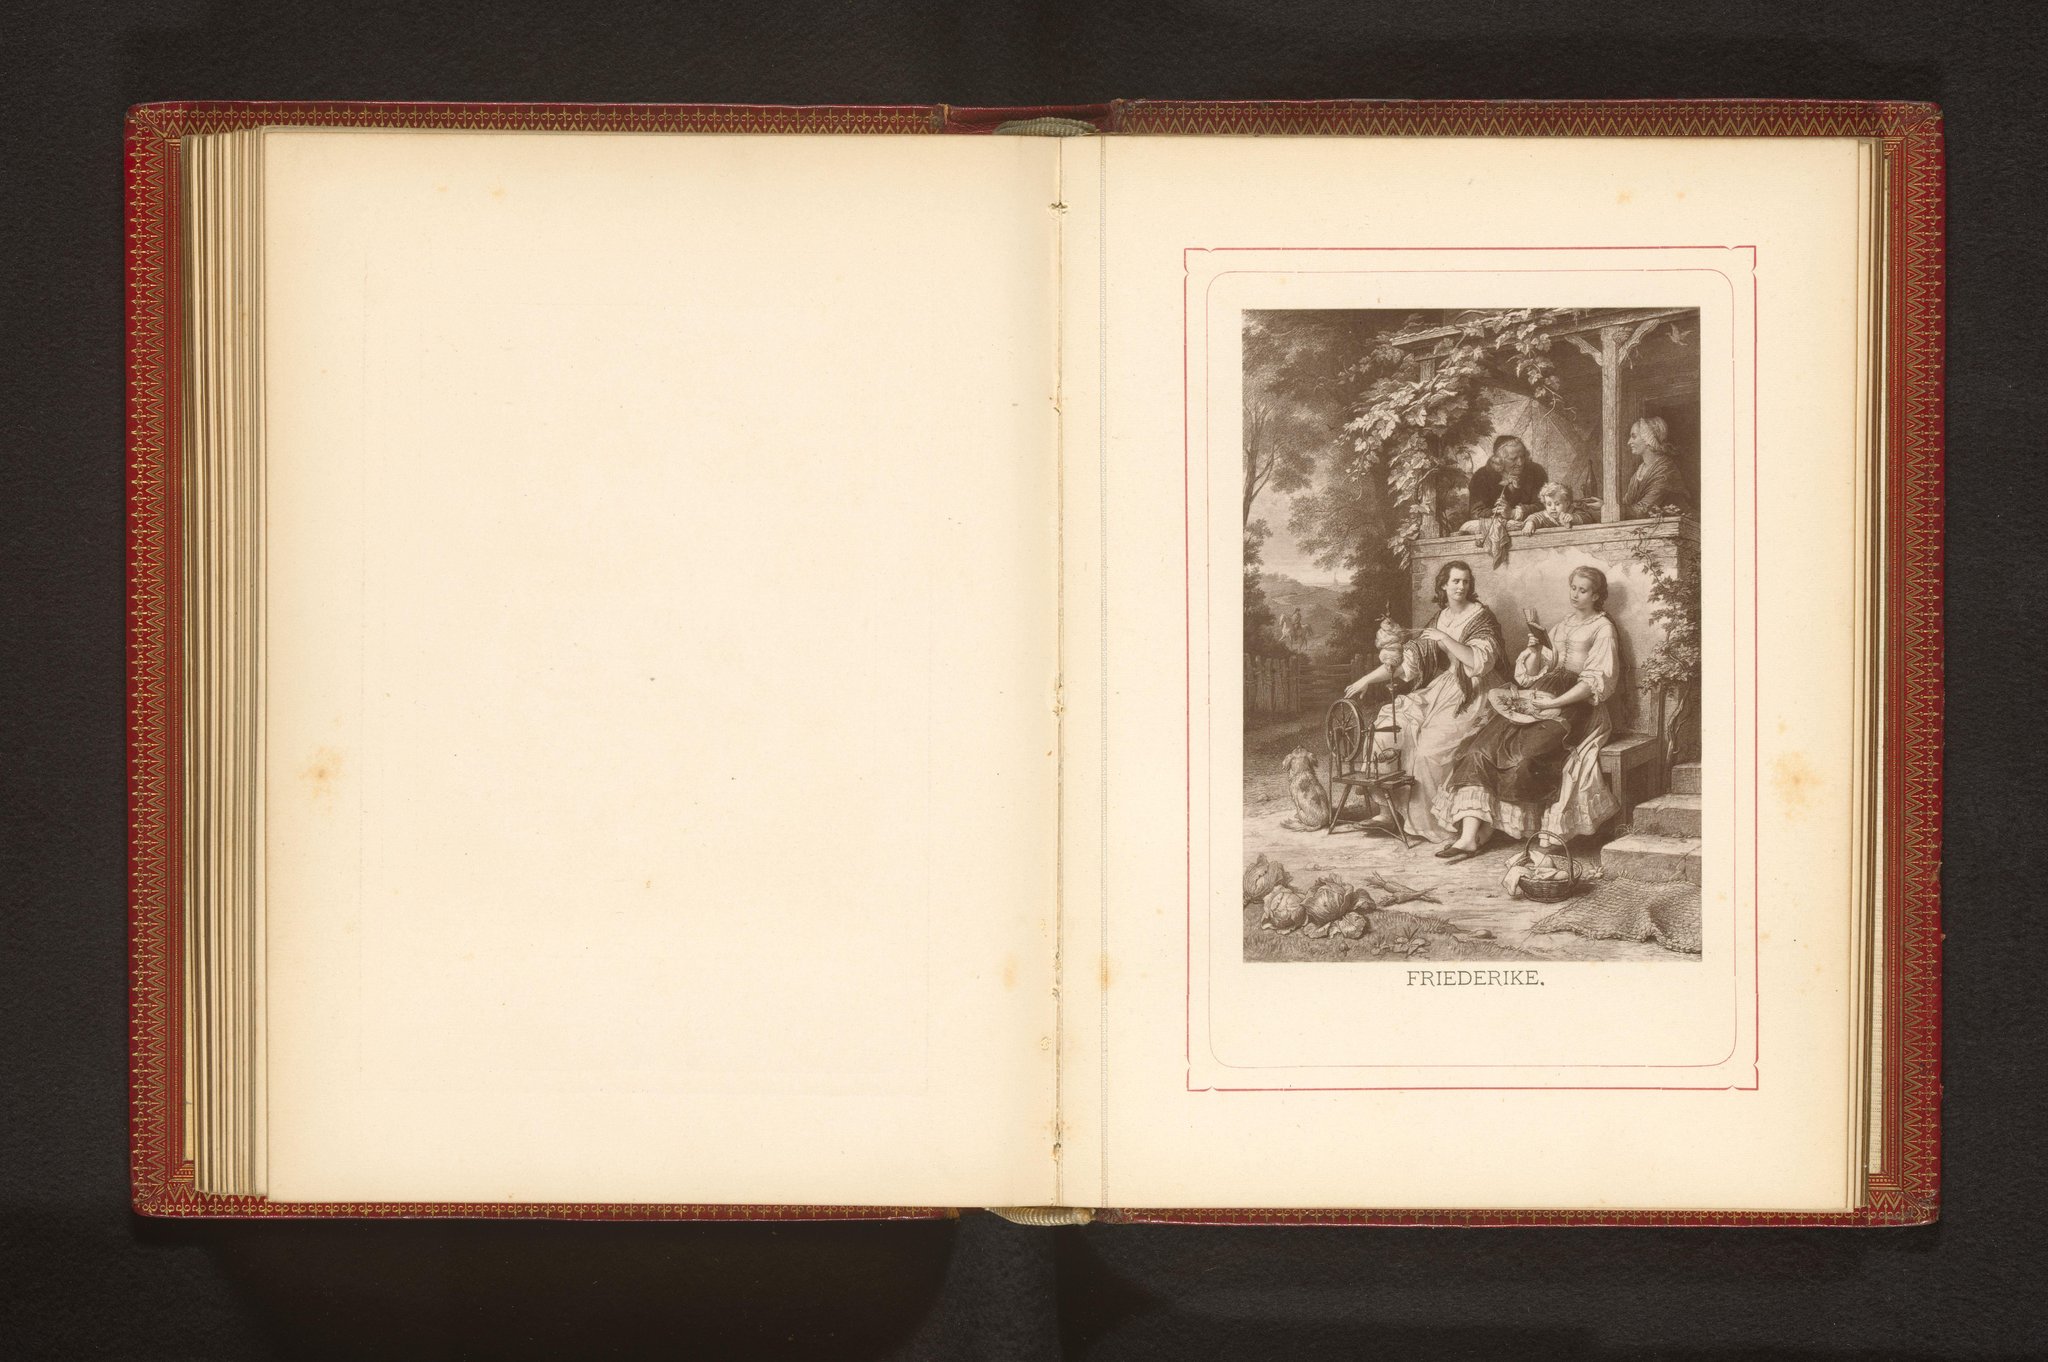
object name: page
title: Fotoreproductie van een tekening, voorstellende Friederike en een spinnende vrouw voor een gebouw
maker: Anonymous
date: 1875-1885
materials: paper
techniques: photograph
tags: adult woman, spinning-wheel, façade (of house or building)